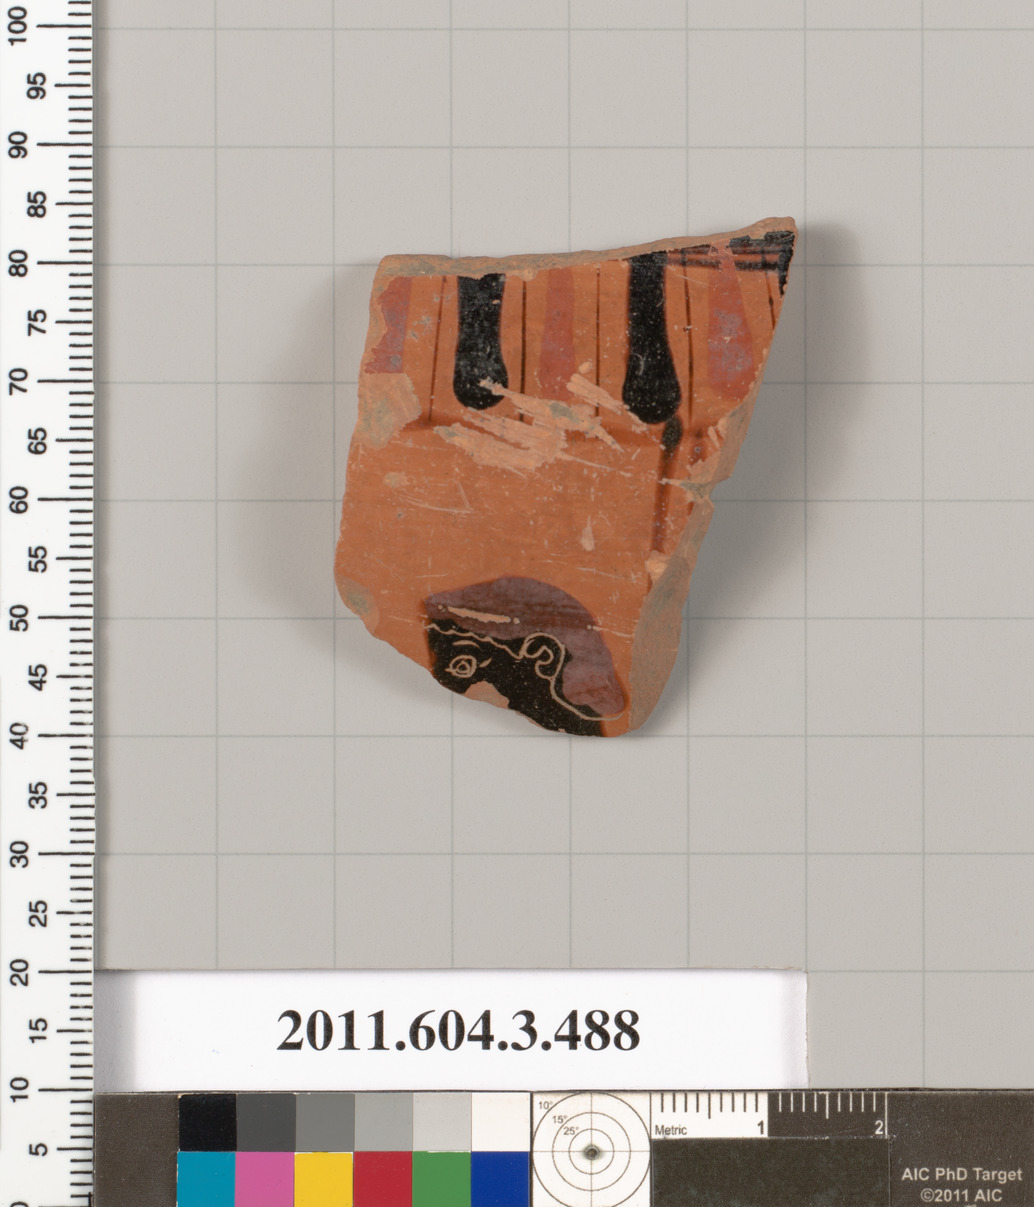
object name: column krater fragment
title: Terracotta fragment of a column-krater (bowl for mixing wine and water)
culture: greek, attic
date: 567-535 BCE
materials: terracotta